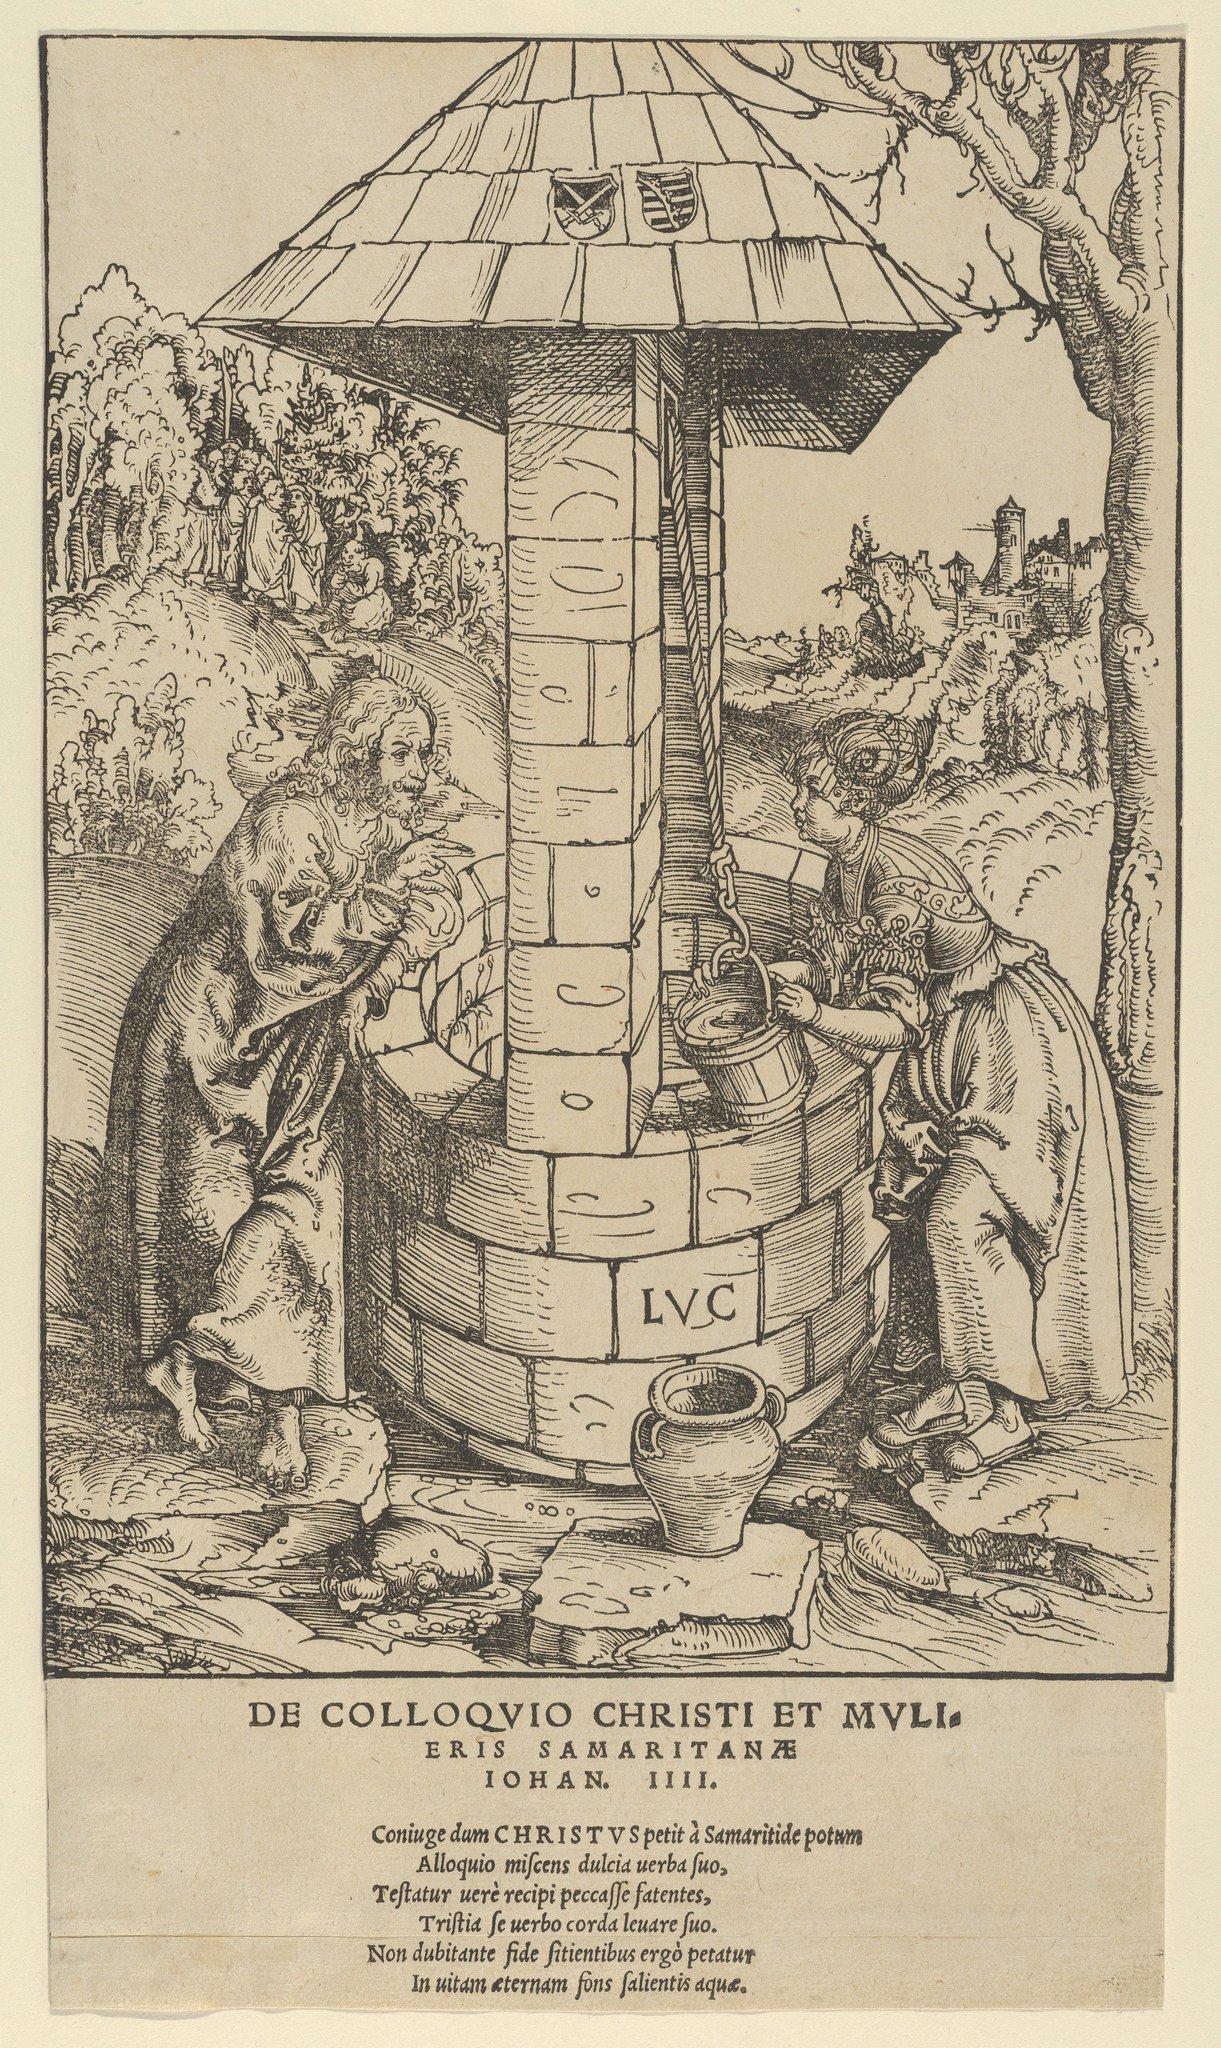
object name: print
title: Christ and the Woman of Samaria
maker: lucas cranach the elder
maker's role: artist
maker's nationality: german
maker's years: 1472-1553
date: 1472-1553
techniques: woodcut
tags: wells,women,christ,working